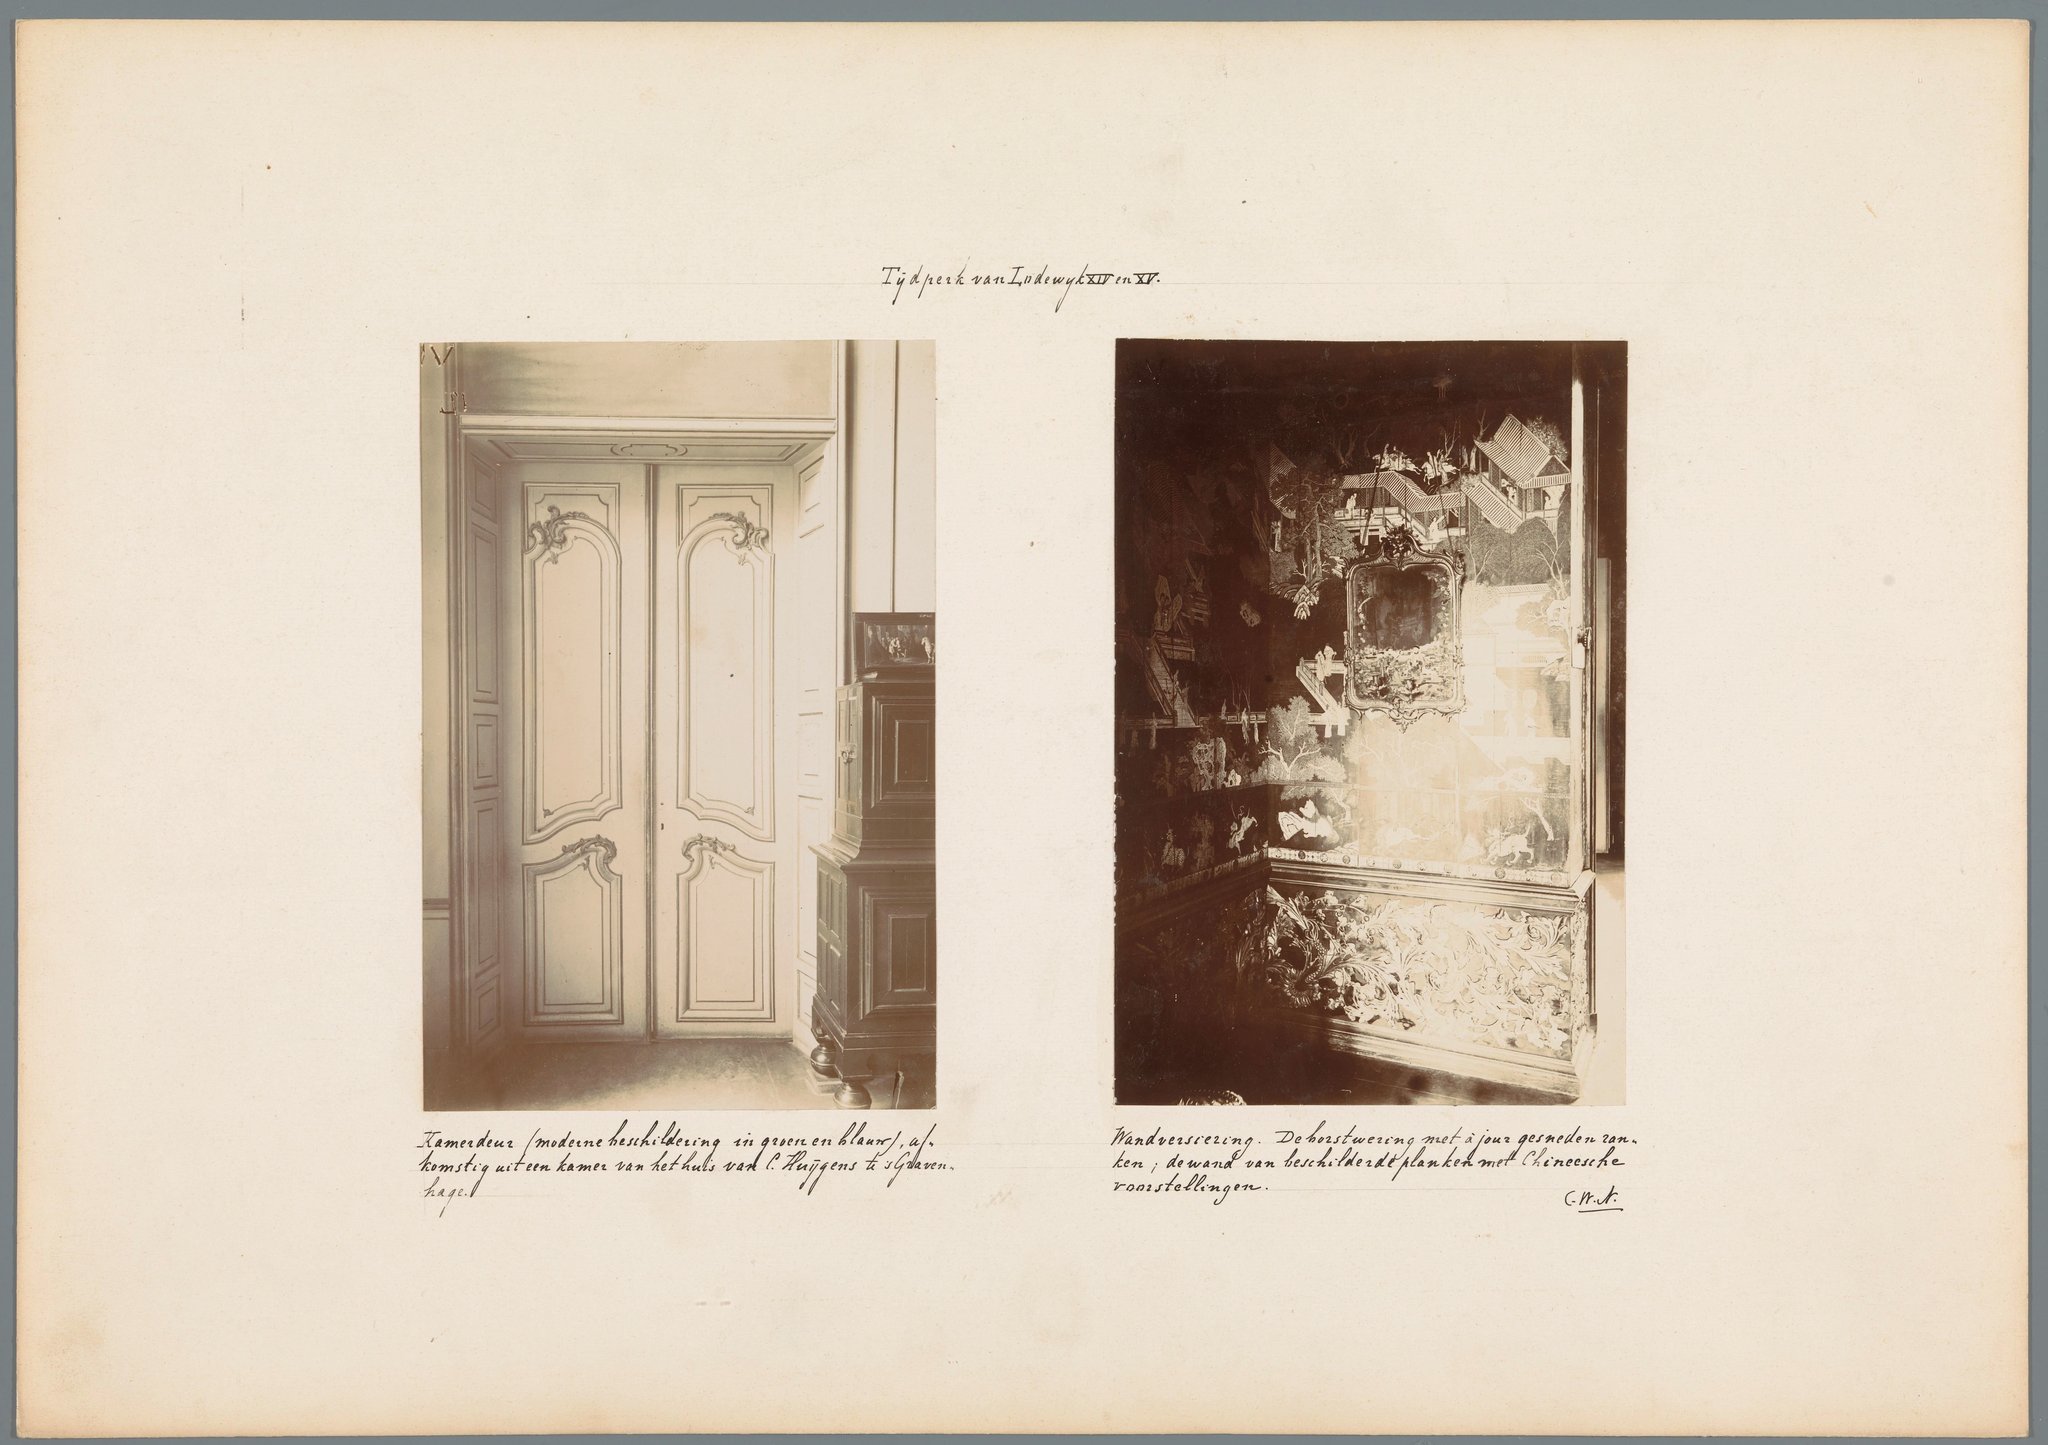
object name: photograph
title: Kamerdeur en een wandbetimmering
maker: Anonymous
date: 1875-1900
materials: cardboard, photographic support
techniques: gelatin silver print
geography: europe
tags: foliage, tendrils, branches ~ ornament - aa - stylized, door, wall-covering, europe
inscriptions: inscription: ‘Tijdperk van Lodewijk XIV en XV.’, inscription: ‘C.W.N.’, collector's mark: ‘KUNSTNIJVERHEIDSCHOOL QUELLINUS AMSTERDAM FRANS HALSSTRAAT 14.’, collector's mark: ‘INSTITUUT VOOR KUNST-NIJVERHEIDSONDERWIJS GABRIËL METSUSTRAAT No. 16 AMSTERDAM’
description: Links een kamerdeur gedecoreerd met een gestileerd bladmotief, rechts een wandbetimmering in Chinees lakwerk, afkomstig uit het paleis van de Friese stadhouders.